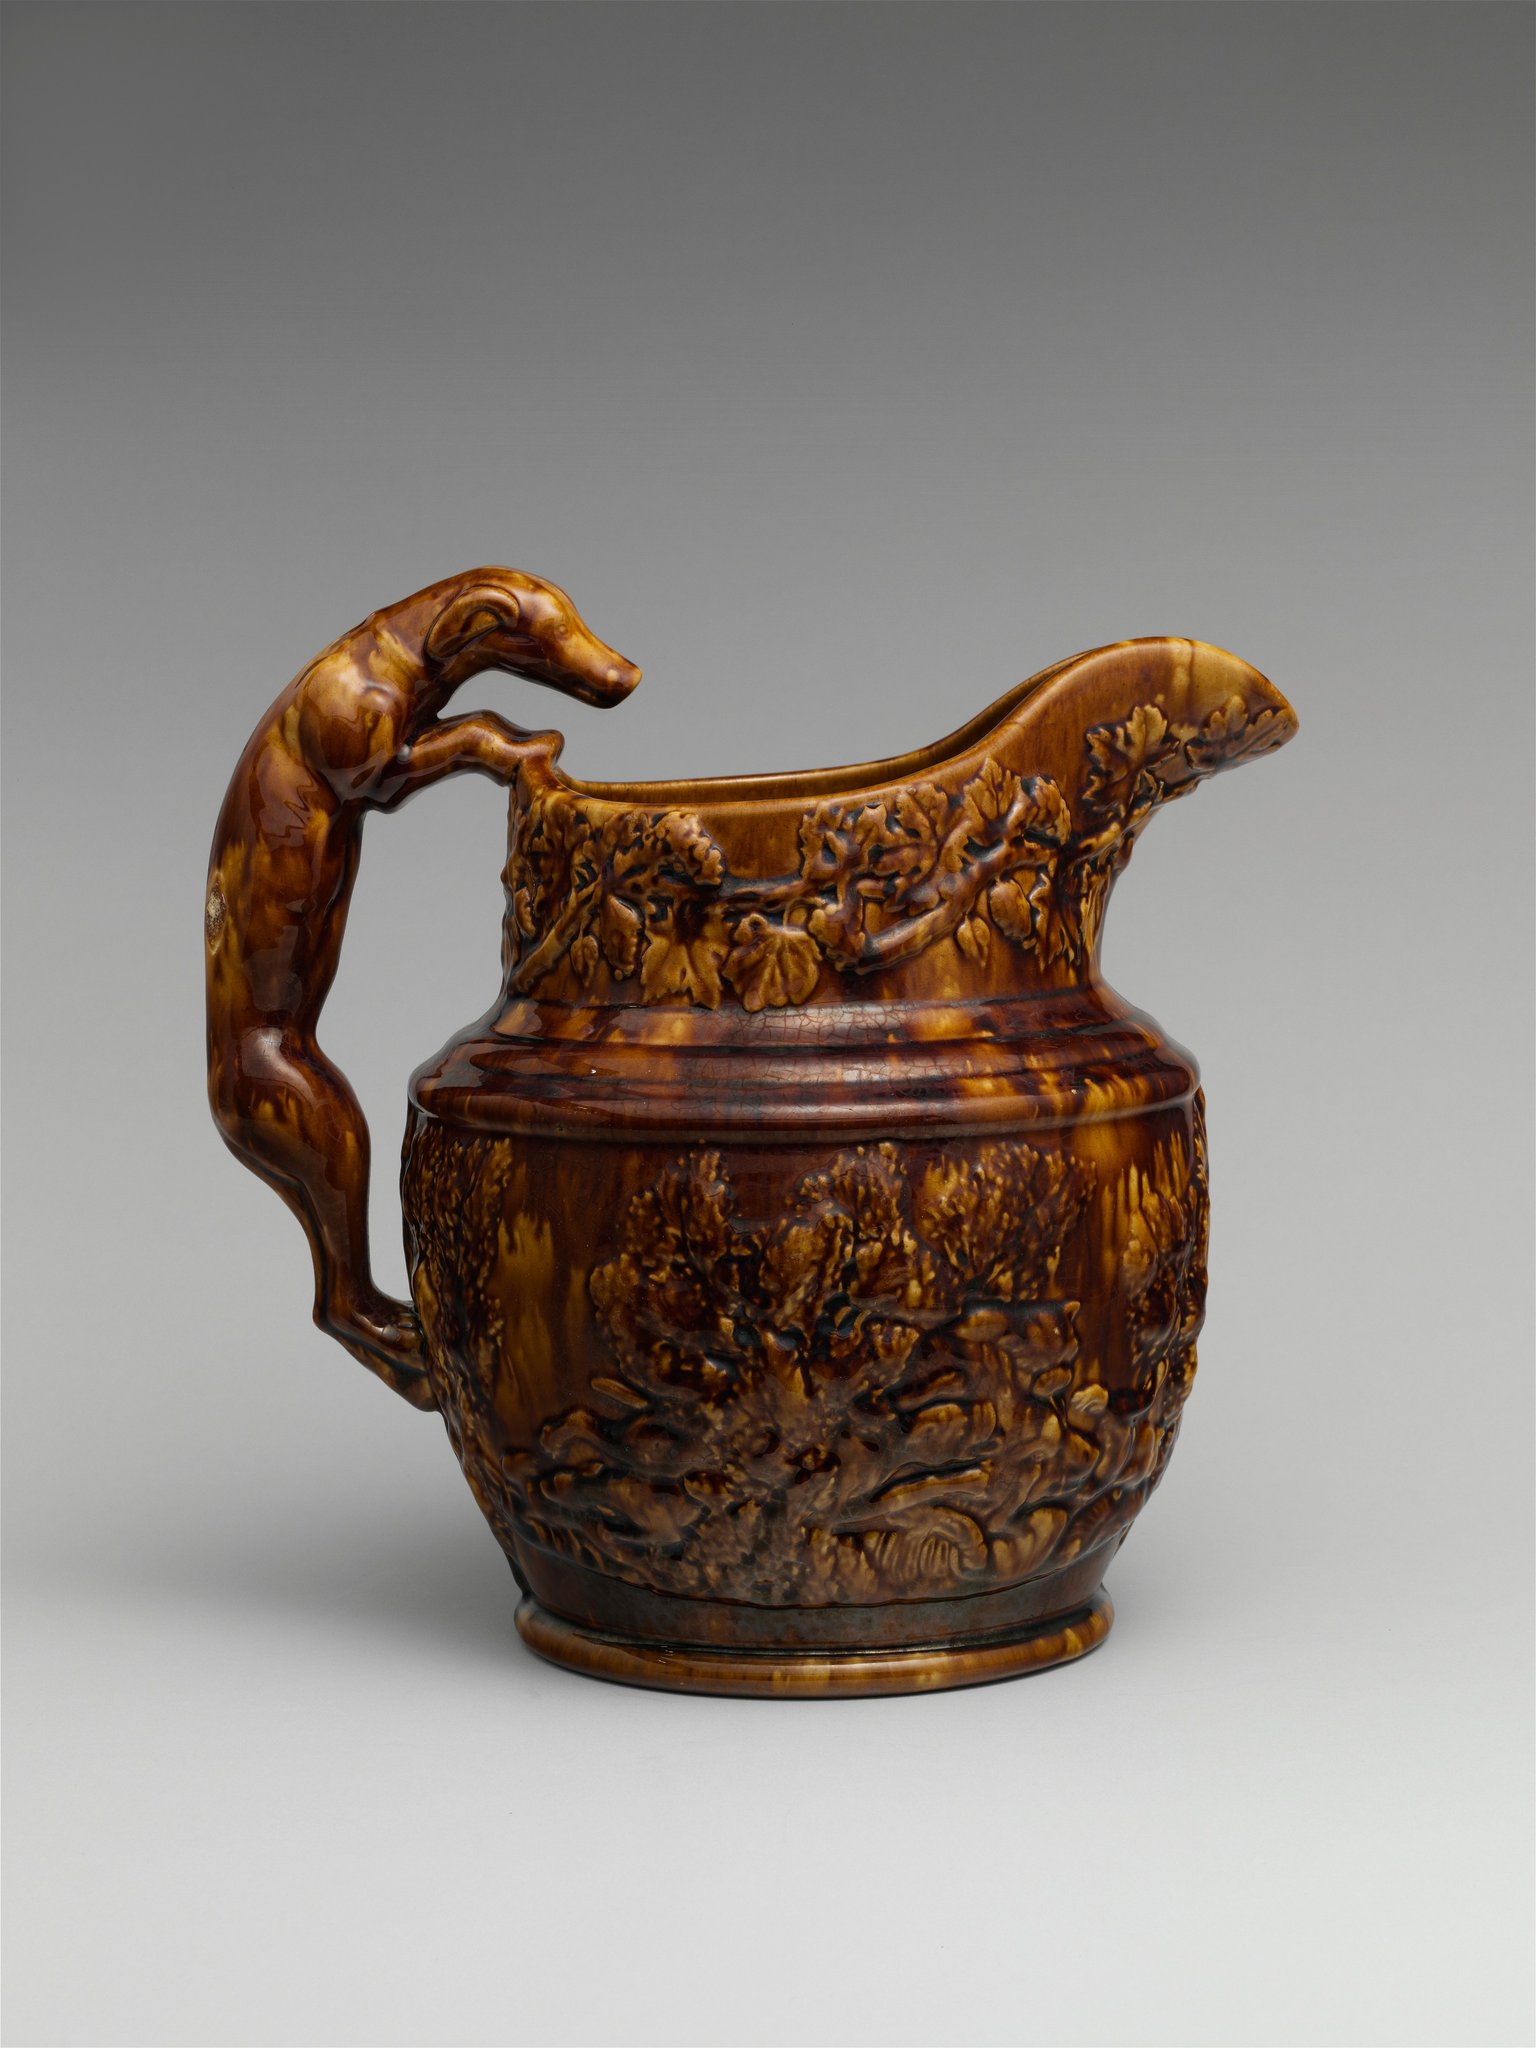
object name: pitcher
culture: american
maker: harker, taylor and company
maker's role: manufacturer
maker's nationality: american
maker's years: 1846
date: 1846-1852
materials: earthenware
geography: united states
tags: dogs